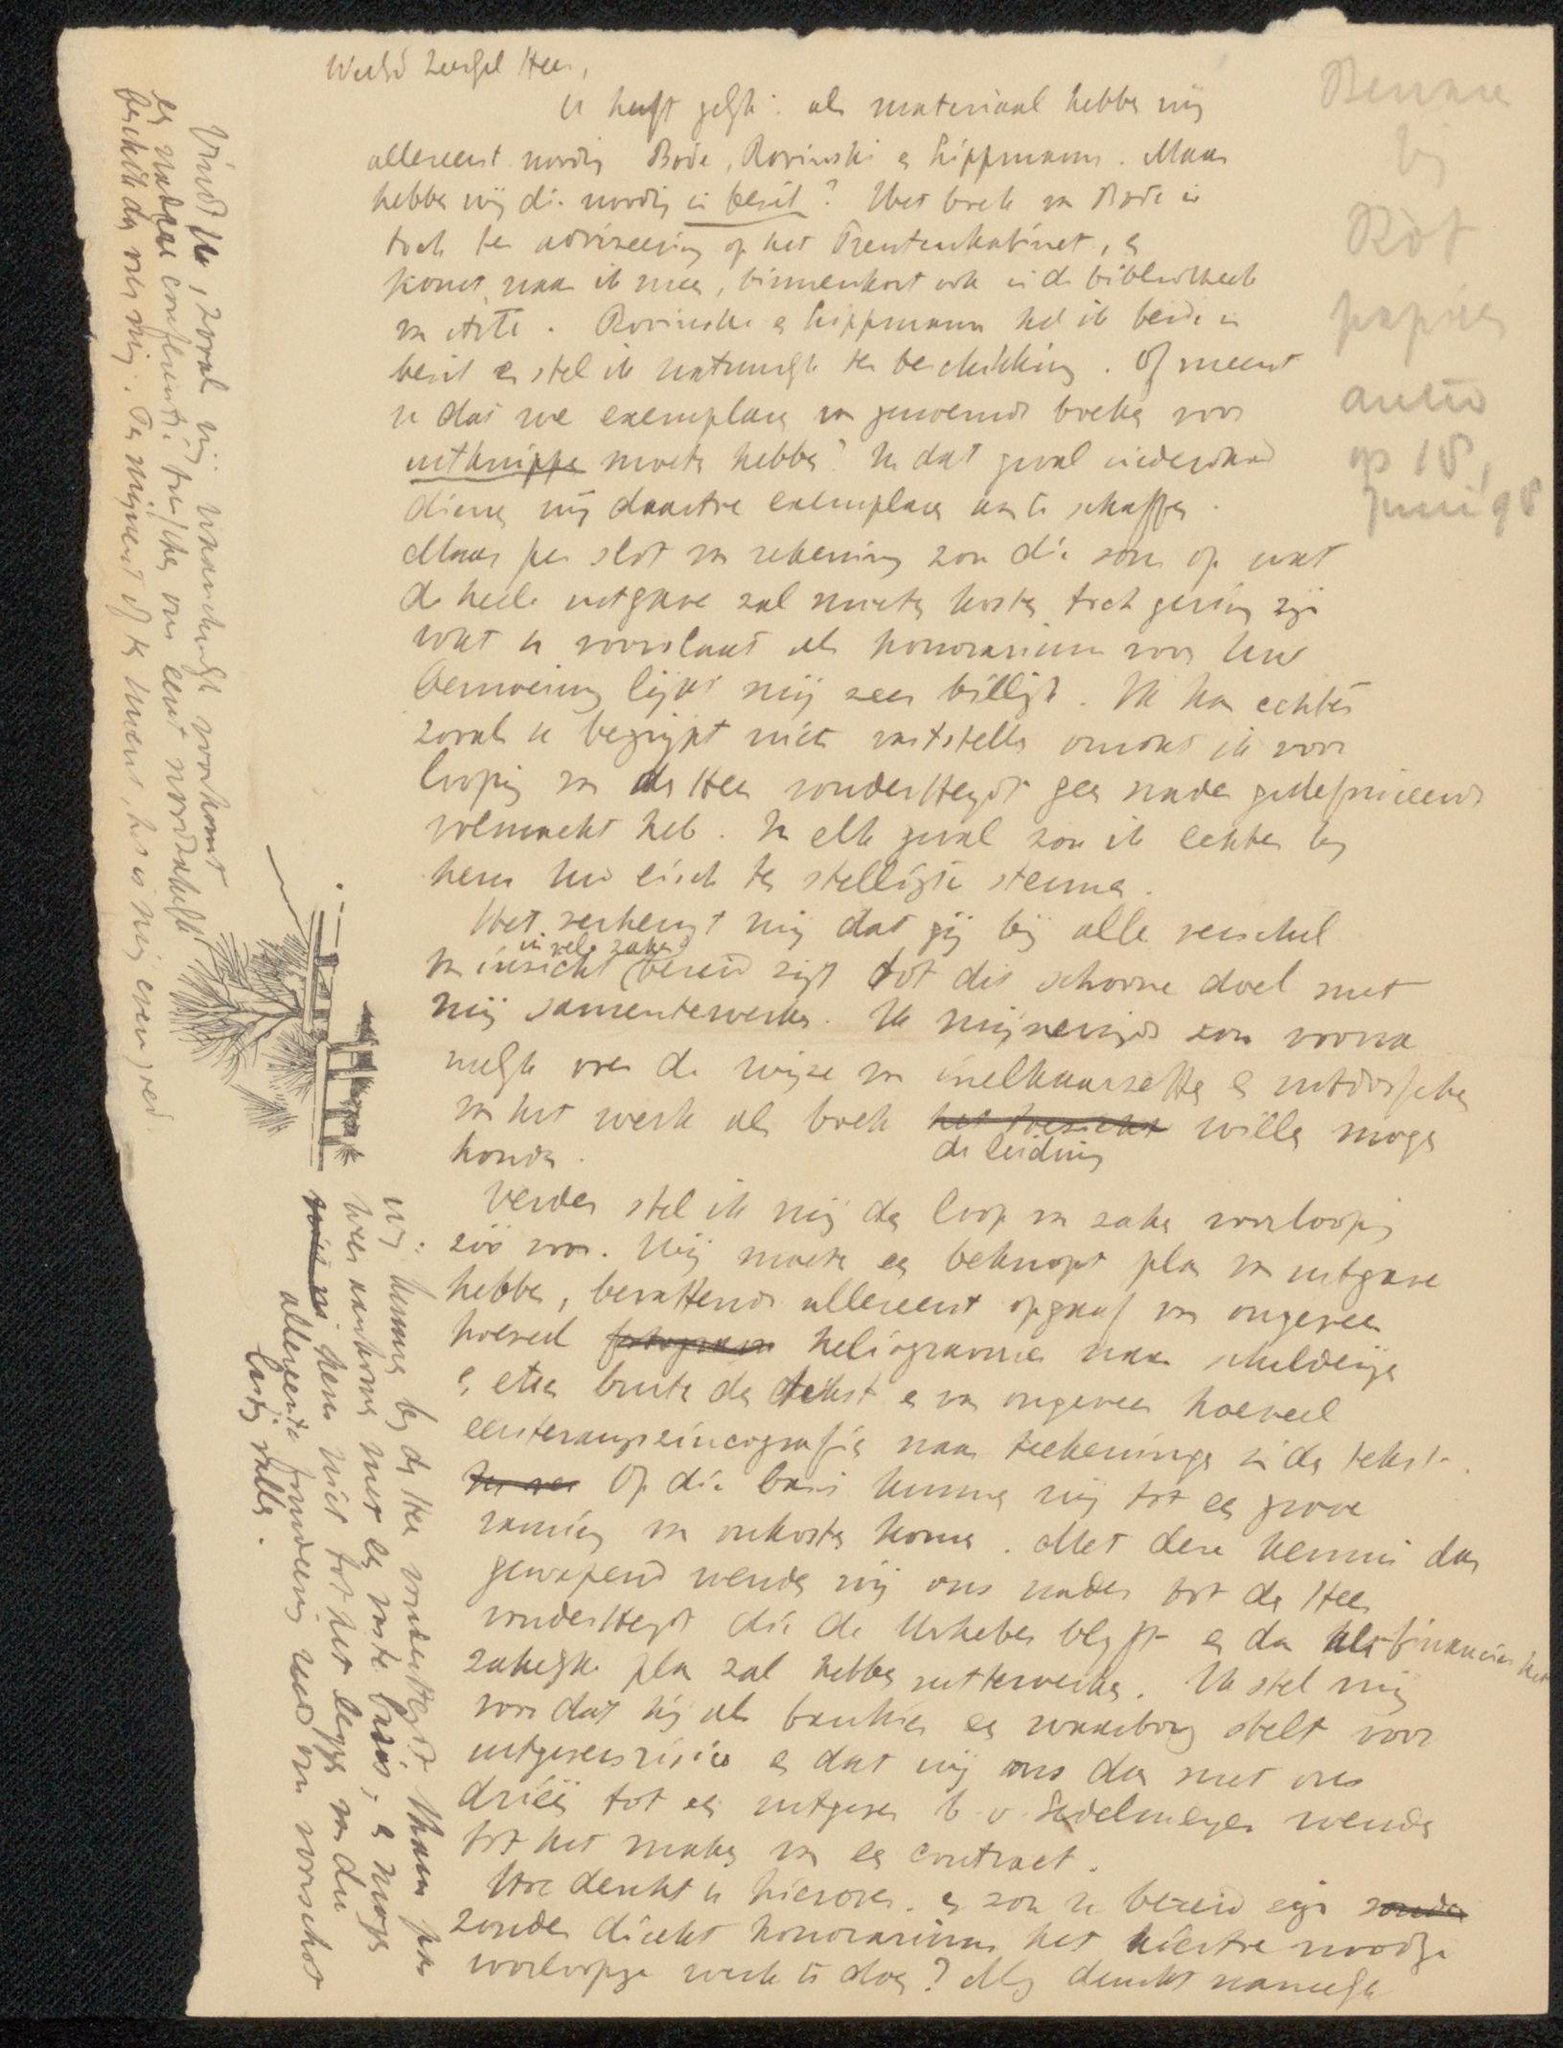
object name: letter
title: Brief aan Cornelis Hofstede de Groot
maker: jan veth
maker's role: designer, draughtsman, painter, print maker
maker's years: 1864-1925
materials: ink, paper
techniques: pen, printing, writing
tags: publisher, charles sedelmeyer, cornelis hofstede de groot, berlin, wilhelm von bode, politician, money, printed matter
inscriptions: collector's mark: ‘RPK’